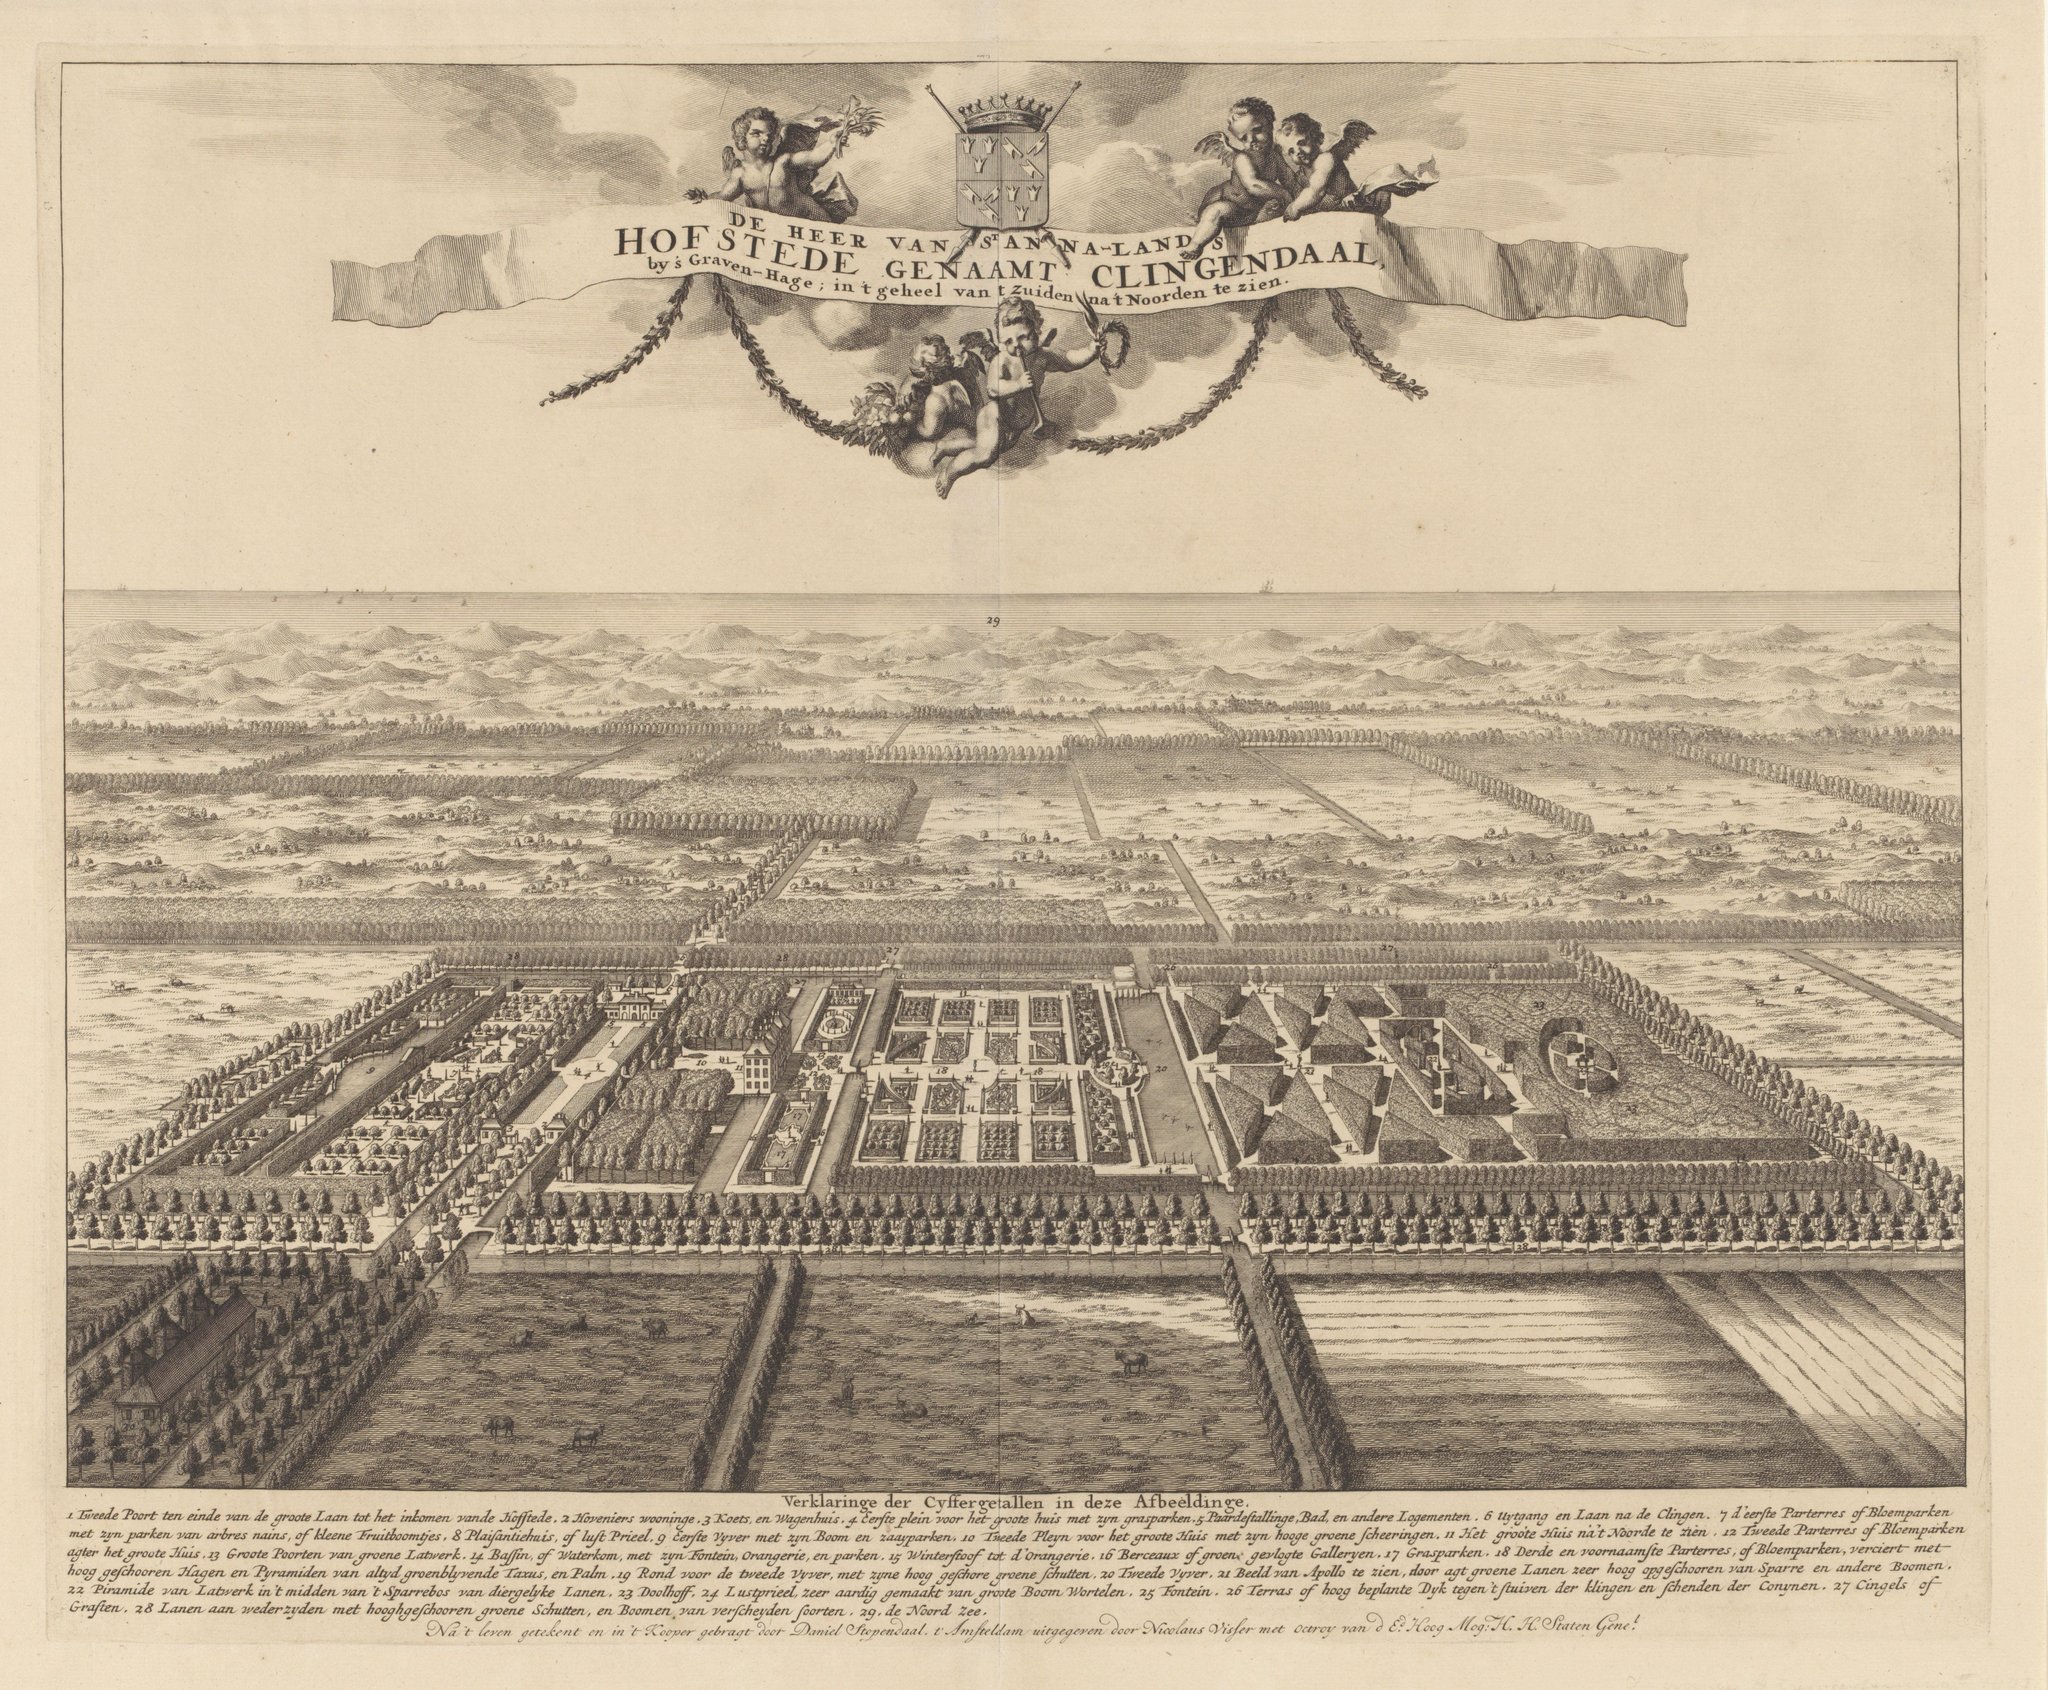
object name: print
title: De heer van St. Anna-lands hofstede genaamt Clingendaal bij 's Gravenhage; in 't geheel van 't zuiden na 't noorden te zien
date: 1682-1726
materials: paper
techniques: engraving, etching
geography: amsterdam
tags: philips doublet (ii), french or architectonic garden; formal garden, bird's eye view ~ representation of building, cupids: 'amores', 'amoretti', 'putti', armorial bearing, heraldry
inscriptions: collector's mark: Lugt 2228, title: ‘De Heer van St. Anna Lands hofstede Genaamt Clingendaal bij 's Gravenhage in 't geheel van 't Zuiden na 't Noorden te zien.’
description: Gezicht op landgoed Clingendael in vogelvlucht. Midden boven een door putti geflankeerde wimpel en het wapenschild van de eigenaar Philips Doublet. Onder in de marge de legenda 1-29.